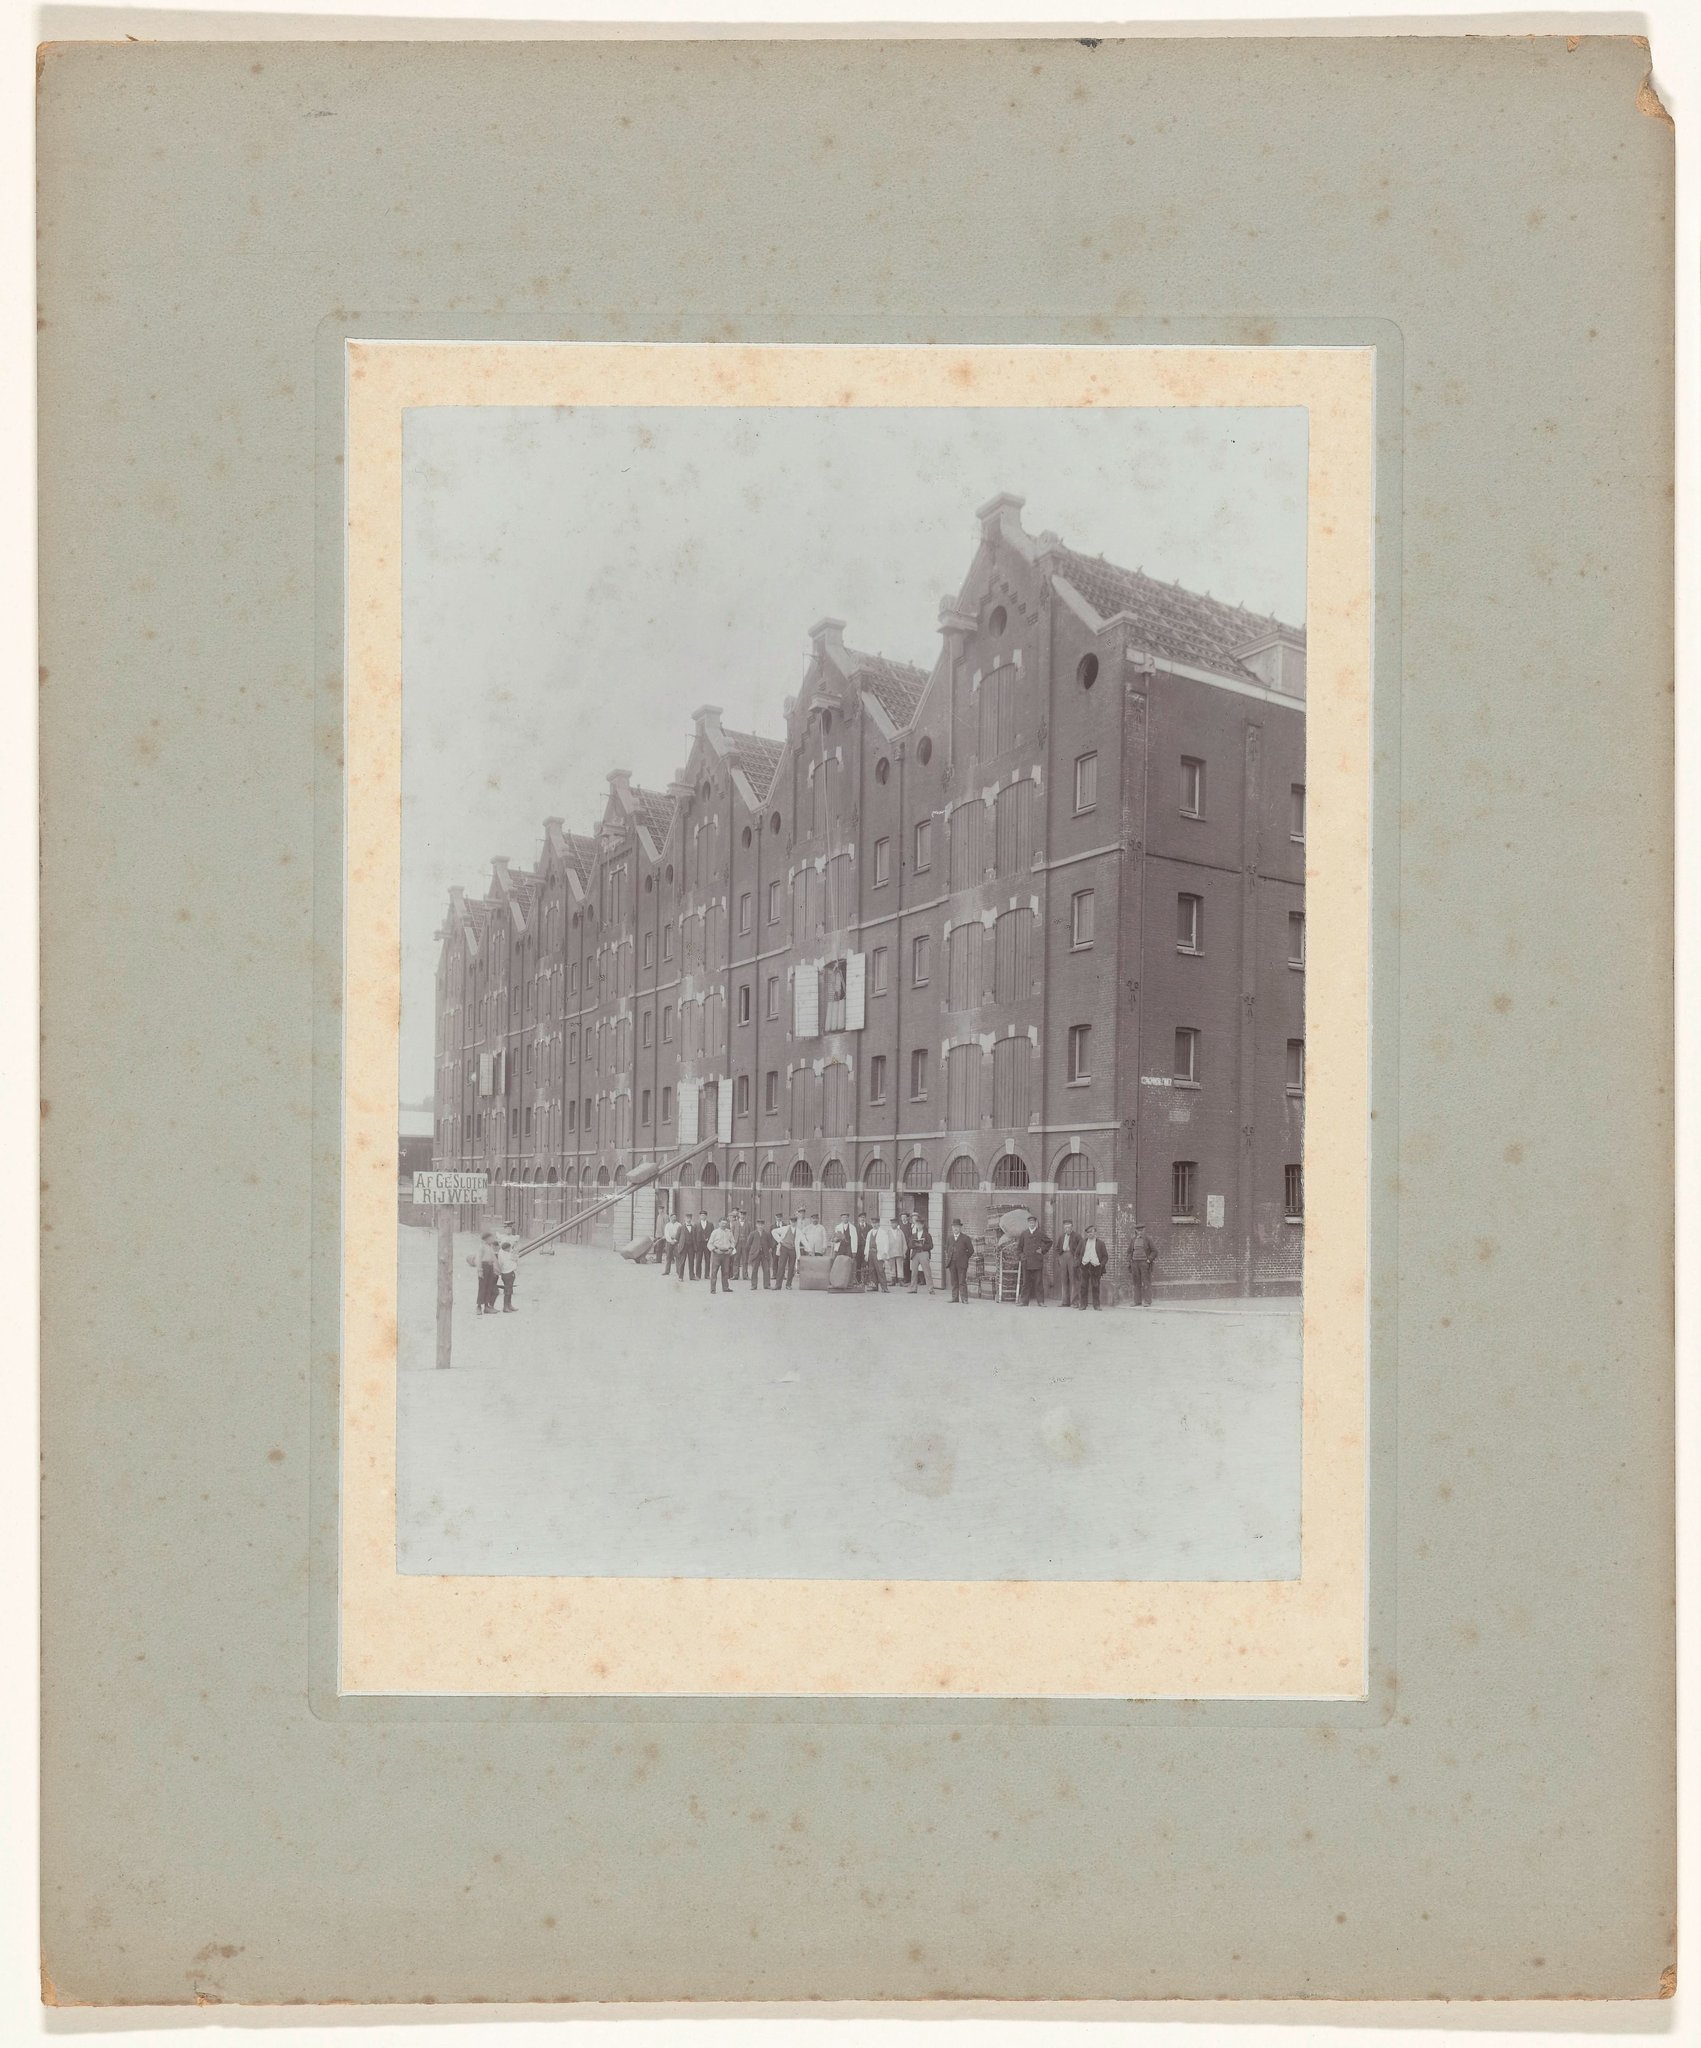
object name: photograph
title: Pakhuizen en arbeiders, Amsterdam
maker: nicolaas schuitvlot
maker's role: fotograaf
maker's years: 1859-1947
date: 1900-1920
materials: paper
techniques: collodion silver print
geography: amsterdam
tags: façade (of house or building), amsterdam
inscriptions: stamp: ‘Nico Schuitvlot Amsterdam’